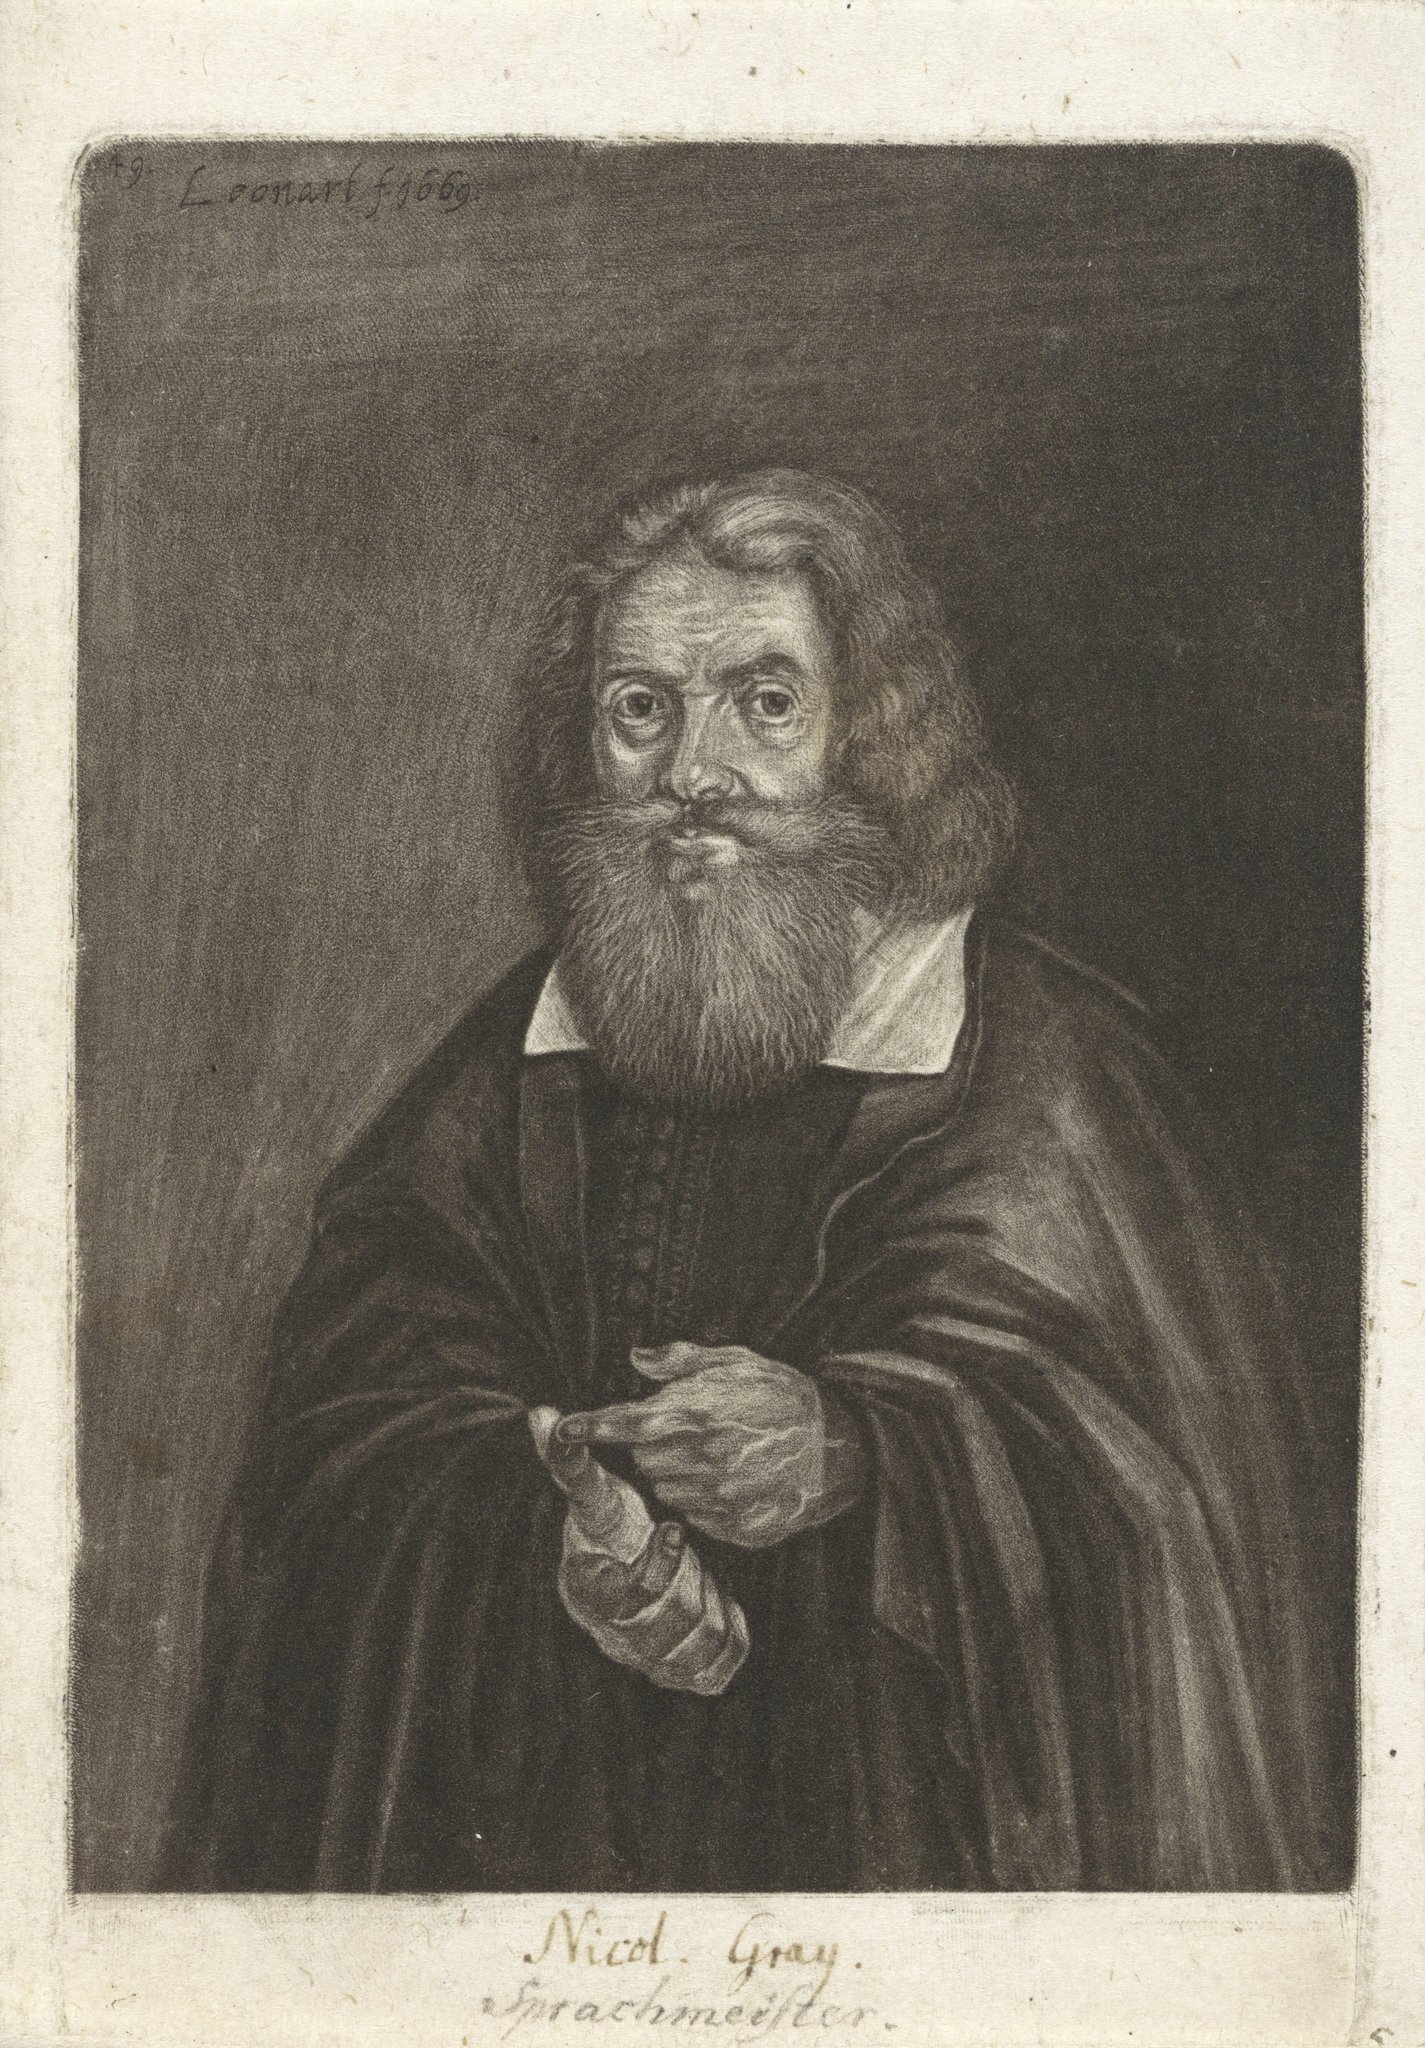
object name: print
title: Portret van een onbekende man, mogelijk Nicol. Grey of Caspar Pusch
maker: johann friedrich leonard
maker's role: print maker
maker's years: 1633-1680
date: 1669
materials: paper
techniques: engraving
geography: nuremberg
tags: nicol. grey, caspar pusch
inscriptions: date